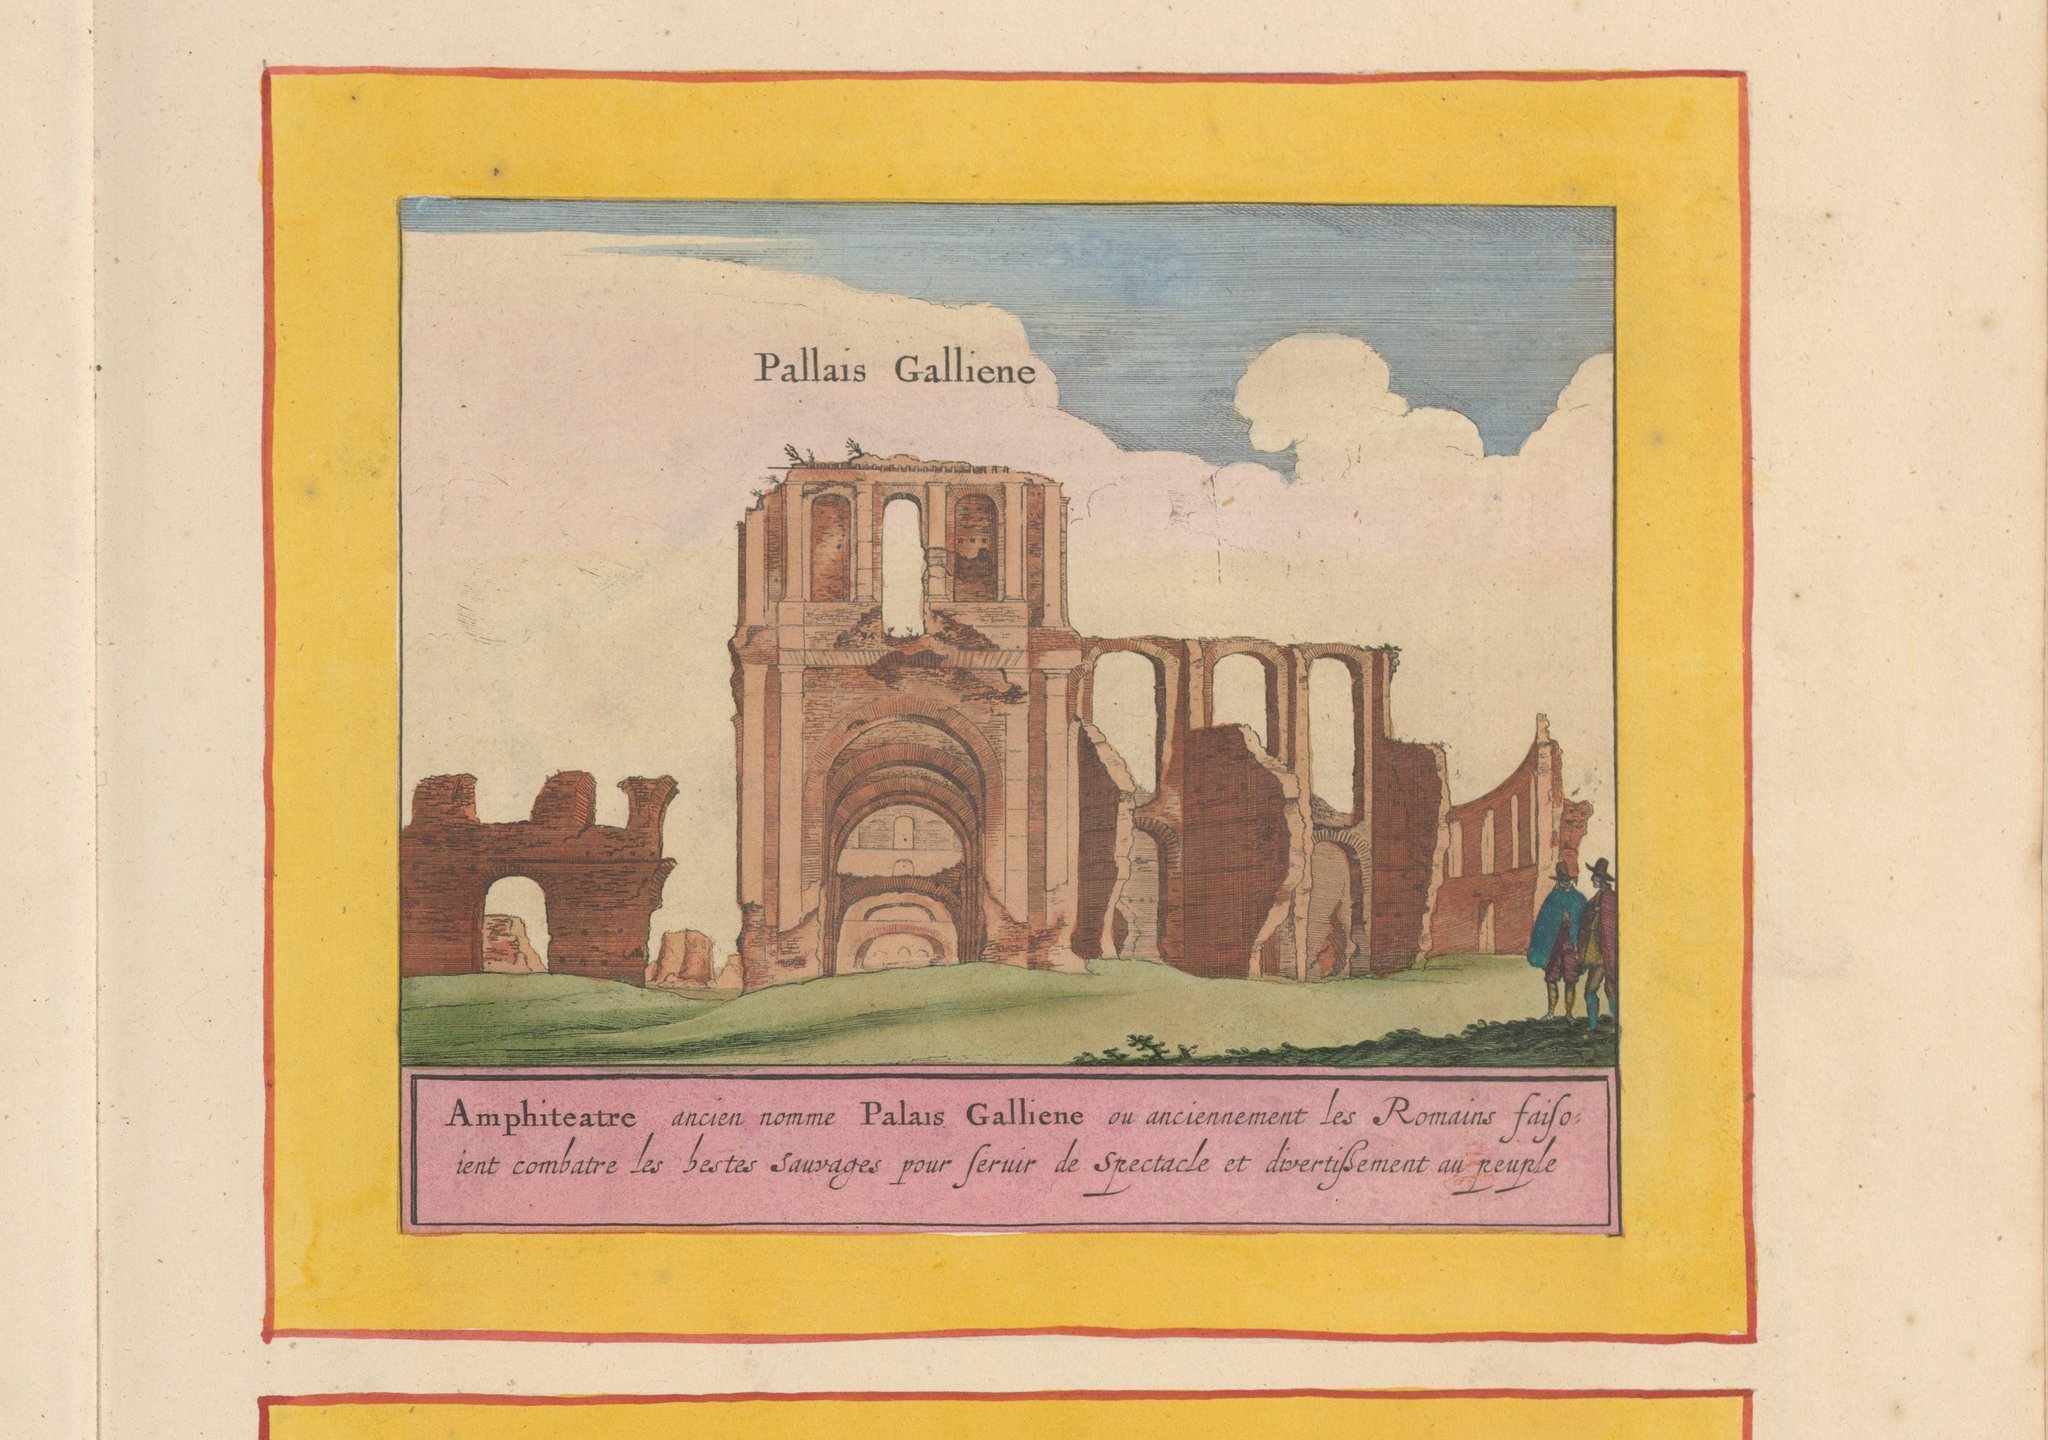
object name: print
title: Pallais Galliene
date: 1650-1699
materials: paper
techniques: engraving, hand coloring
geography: the hague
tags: amphitheatre, landscape with ruins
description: Deze prent maakt deel uit van een album.